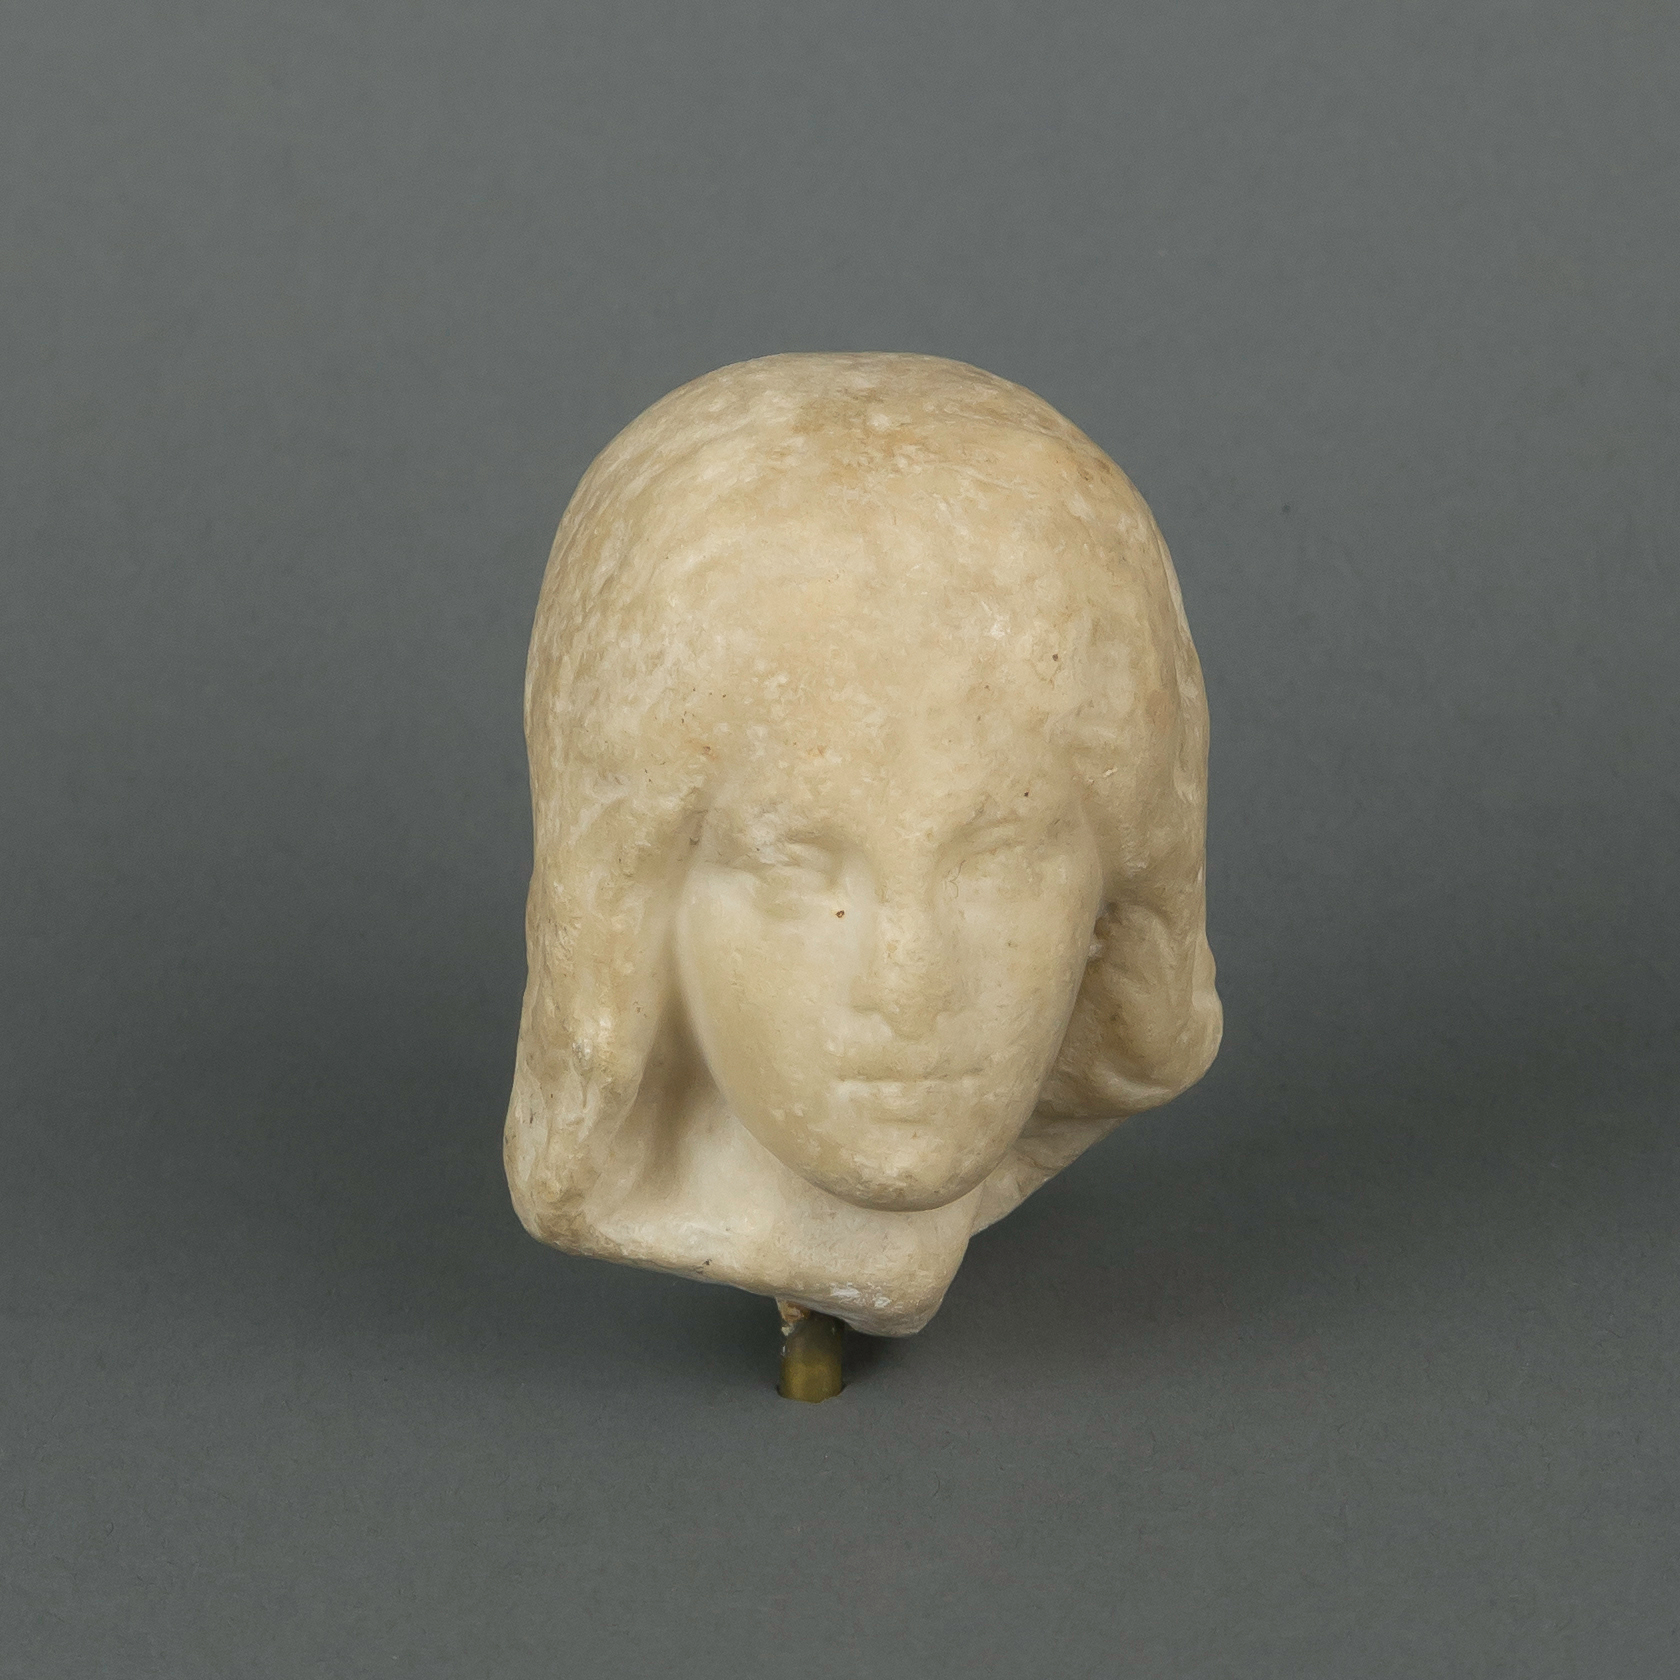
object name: head of aphrodite anadyomene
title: Marble head of a female statuette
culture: roman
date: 1-200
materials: marble